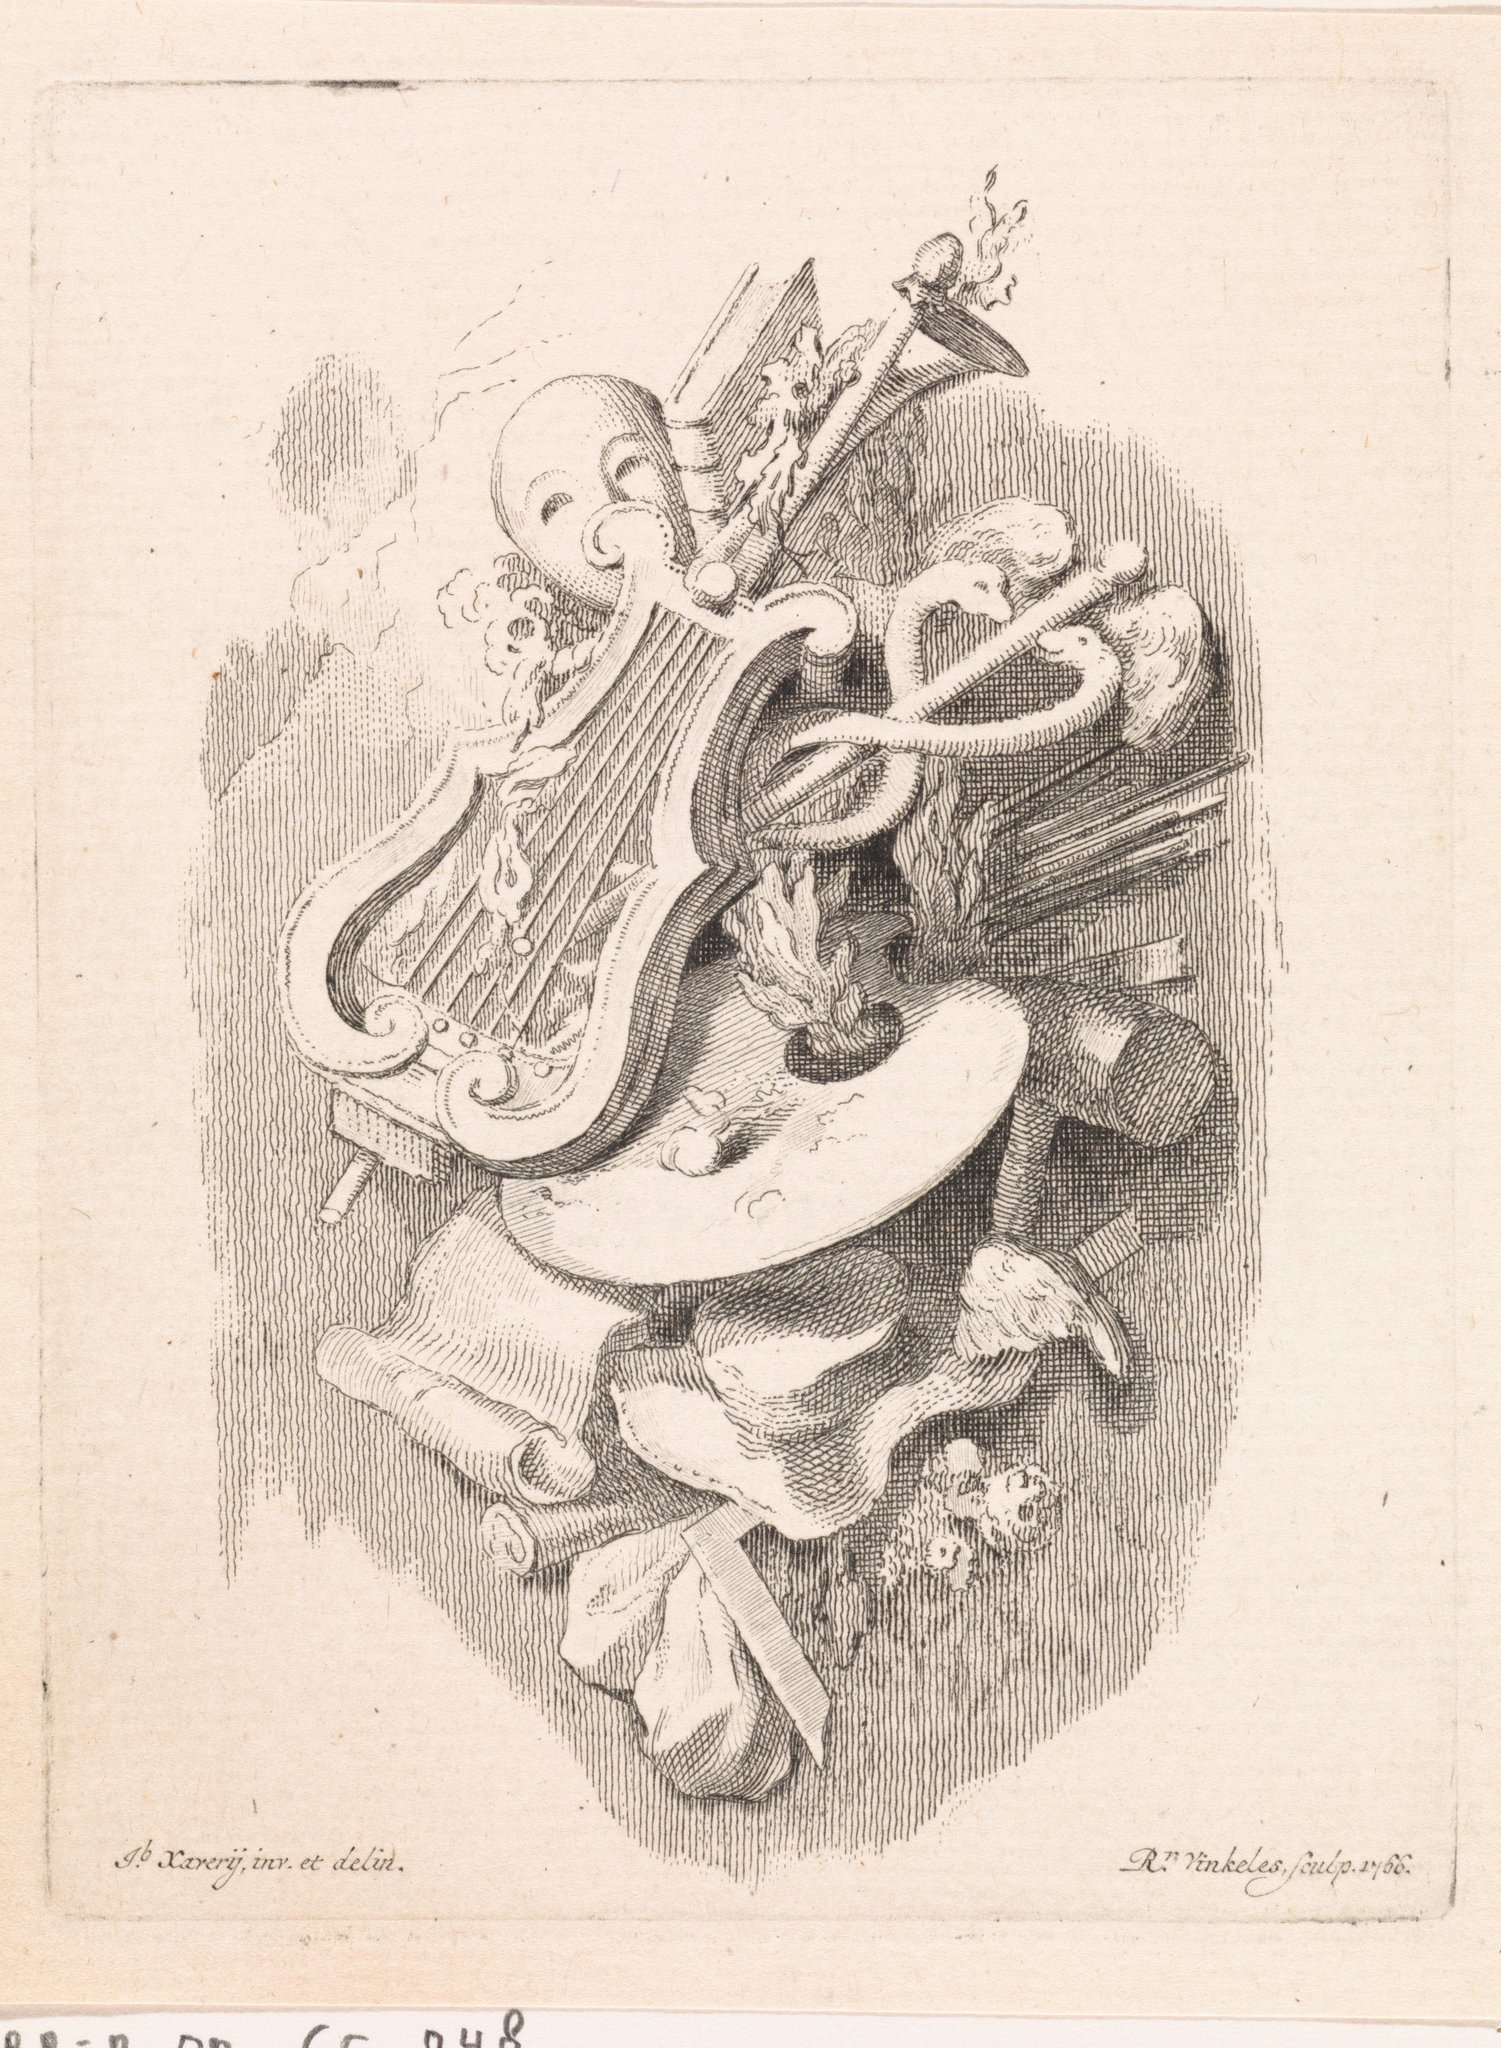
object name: print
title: Trofee van kunstattributen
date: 1766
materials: paper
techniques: engraving, etching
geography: amsterdam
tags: trophy, i.e.: decorative arrangement of symbolic or typical objects ~ ornament, symbolic representations, allegories and emblems ~ art; 'arte' (ripa)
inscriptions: collector's mark: Lugt 240